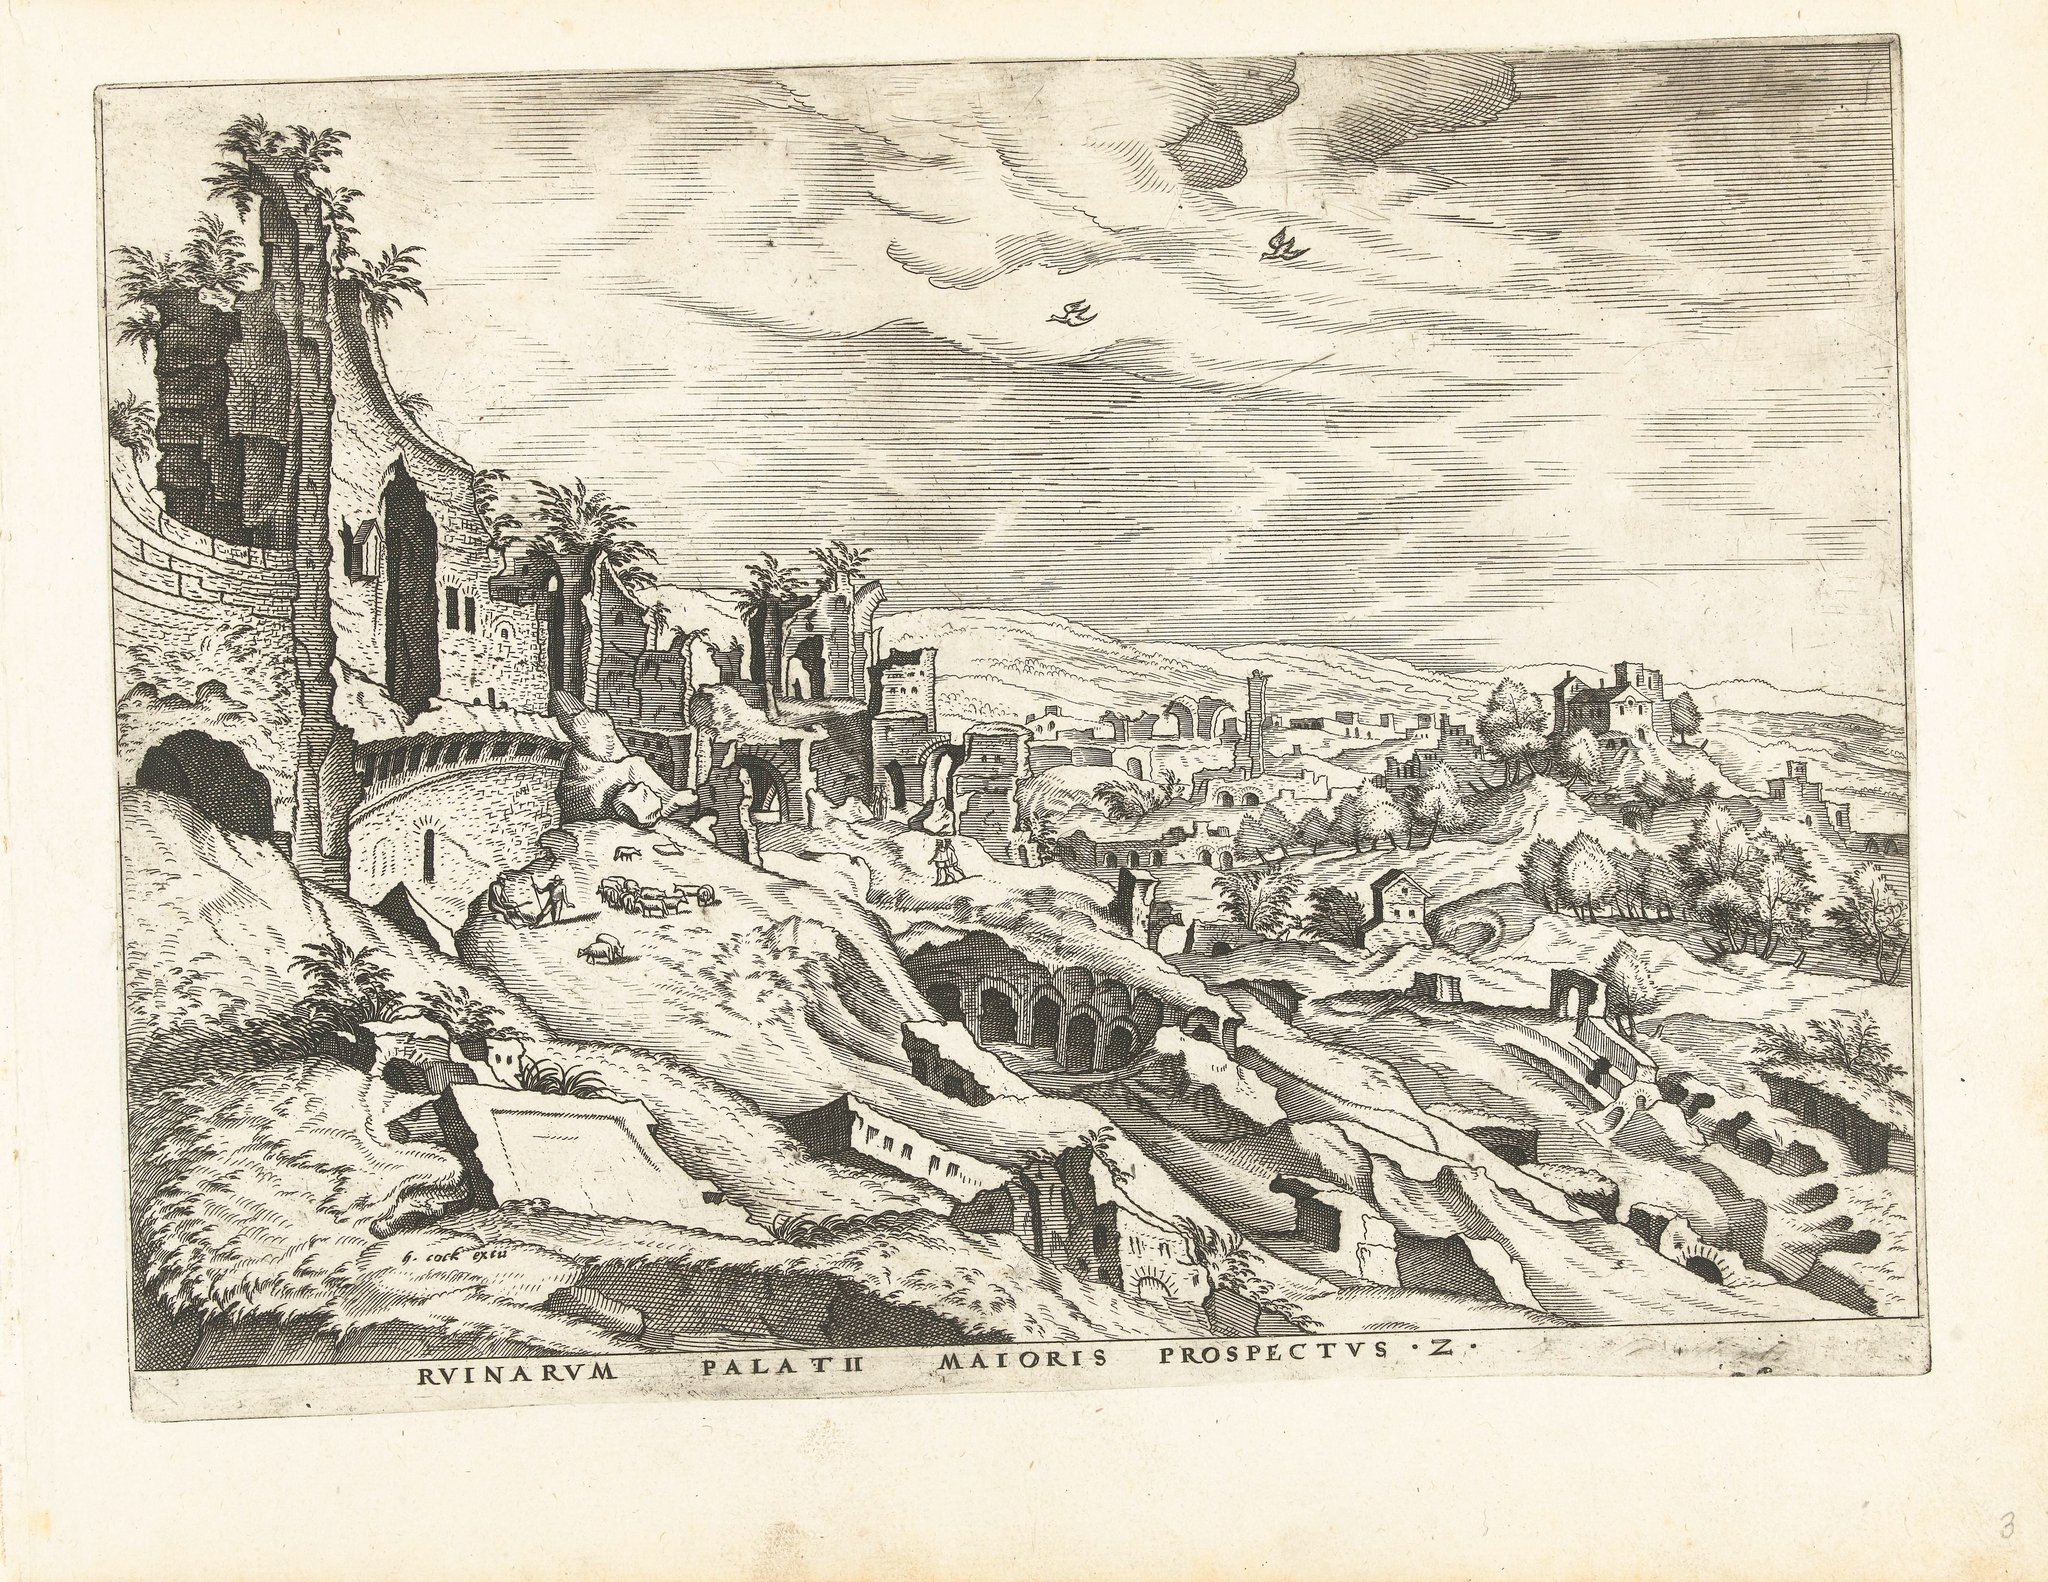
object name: print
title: Tweede gezicht op de Palatijn in Rome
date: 1561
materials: paper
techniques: engraving, etching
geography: amsterdam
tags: landscape with ruins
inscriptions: watermark: Briquet 9320-30, collector's mark: Lugt 2228, collector's mark: Lugt 2760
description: Tweede gezicht op de ruïnes van de Palatijn in Rome. Een schaapherder laat zijn kudde grazen tussen de gebouwen.